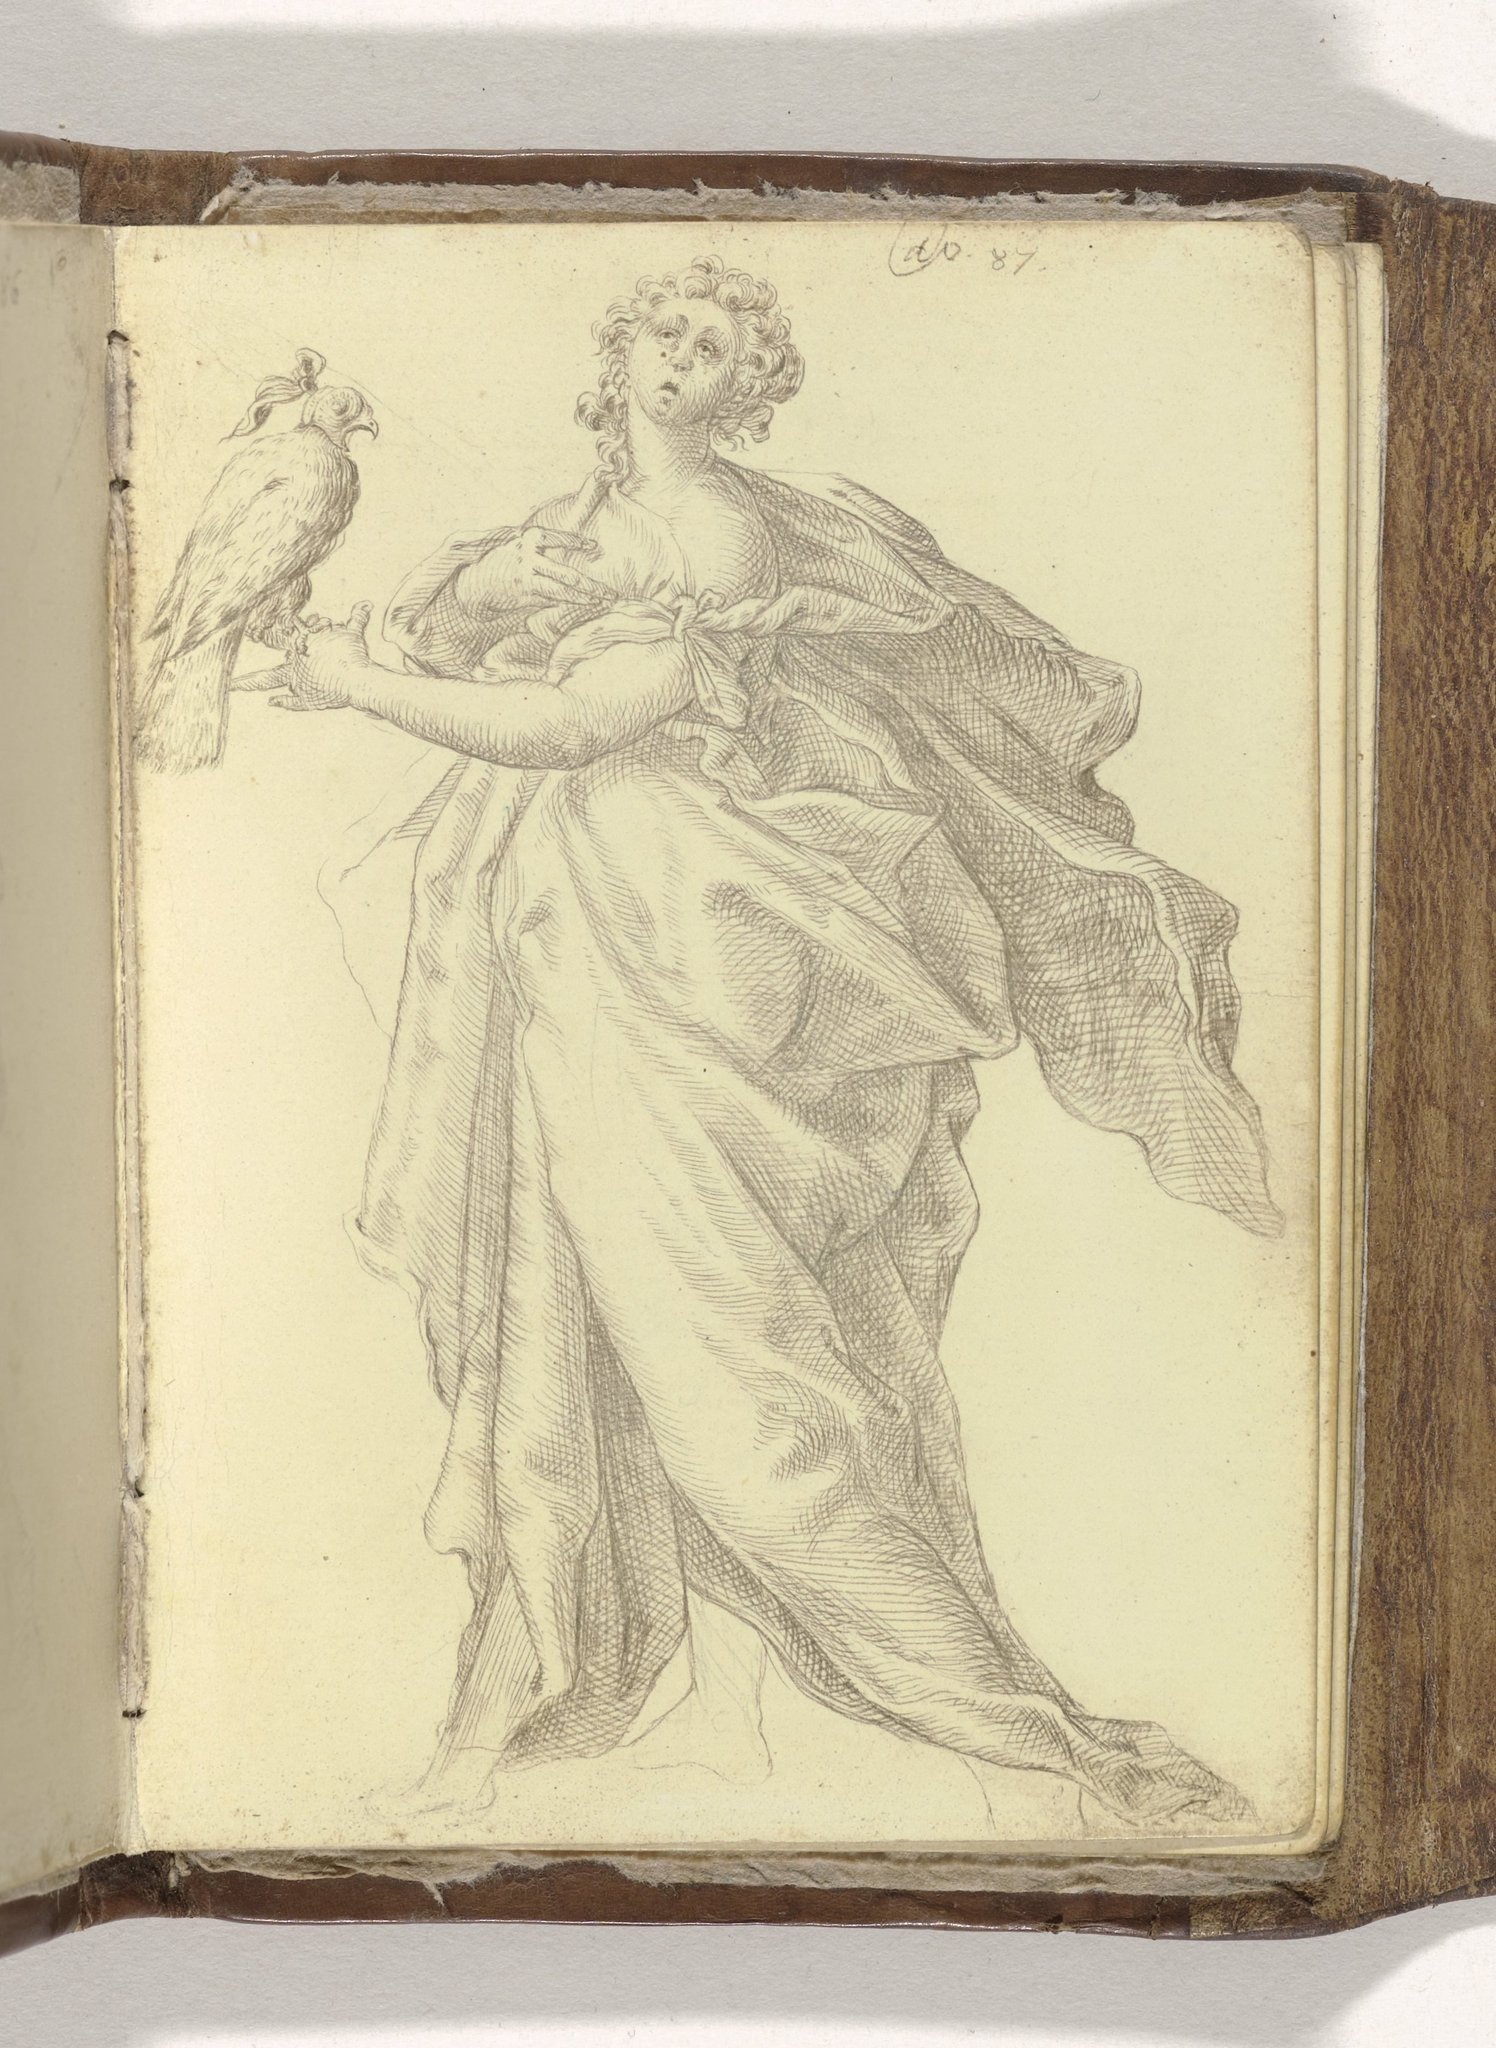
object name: drawing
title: Vrouw met valk op haar linkerhand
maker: Anonymous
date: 1587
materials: paper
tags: predatory birds: falcon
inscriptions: date